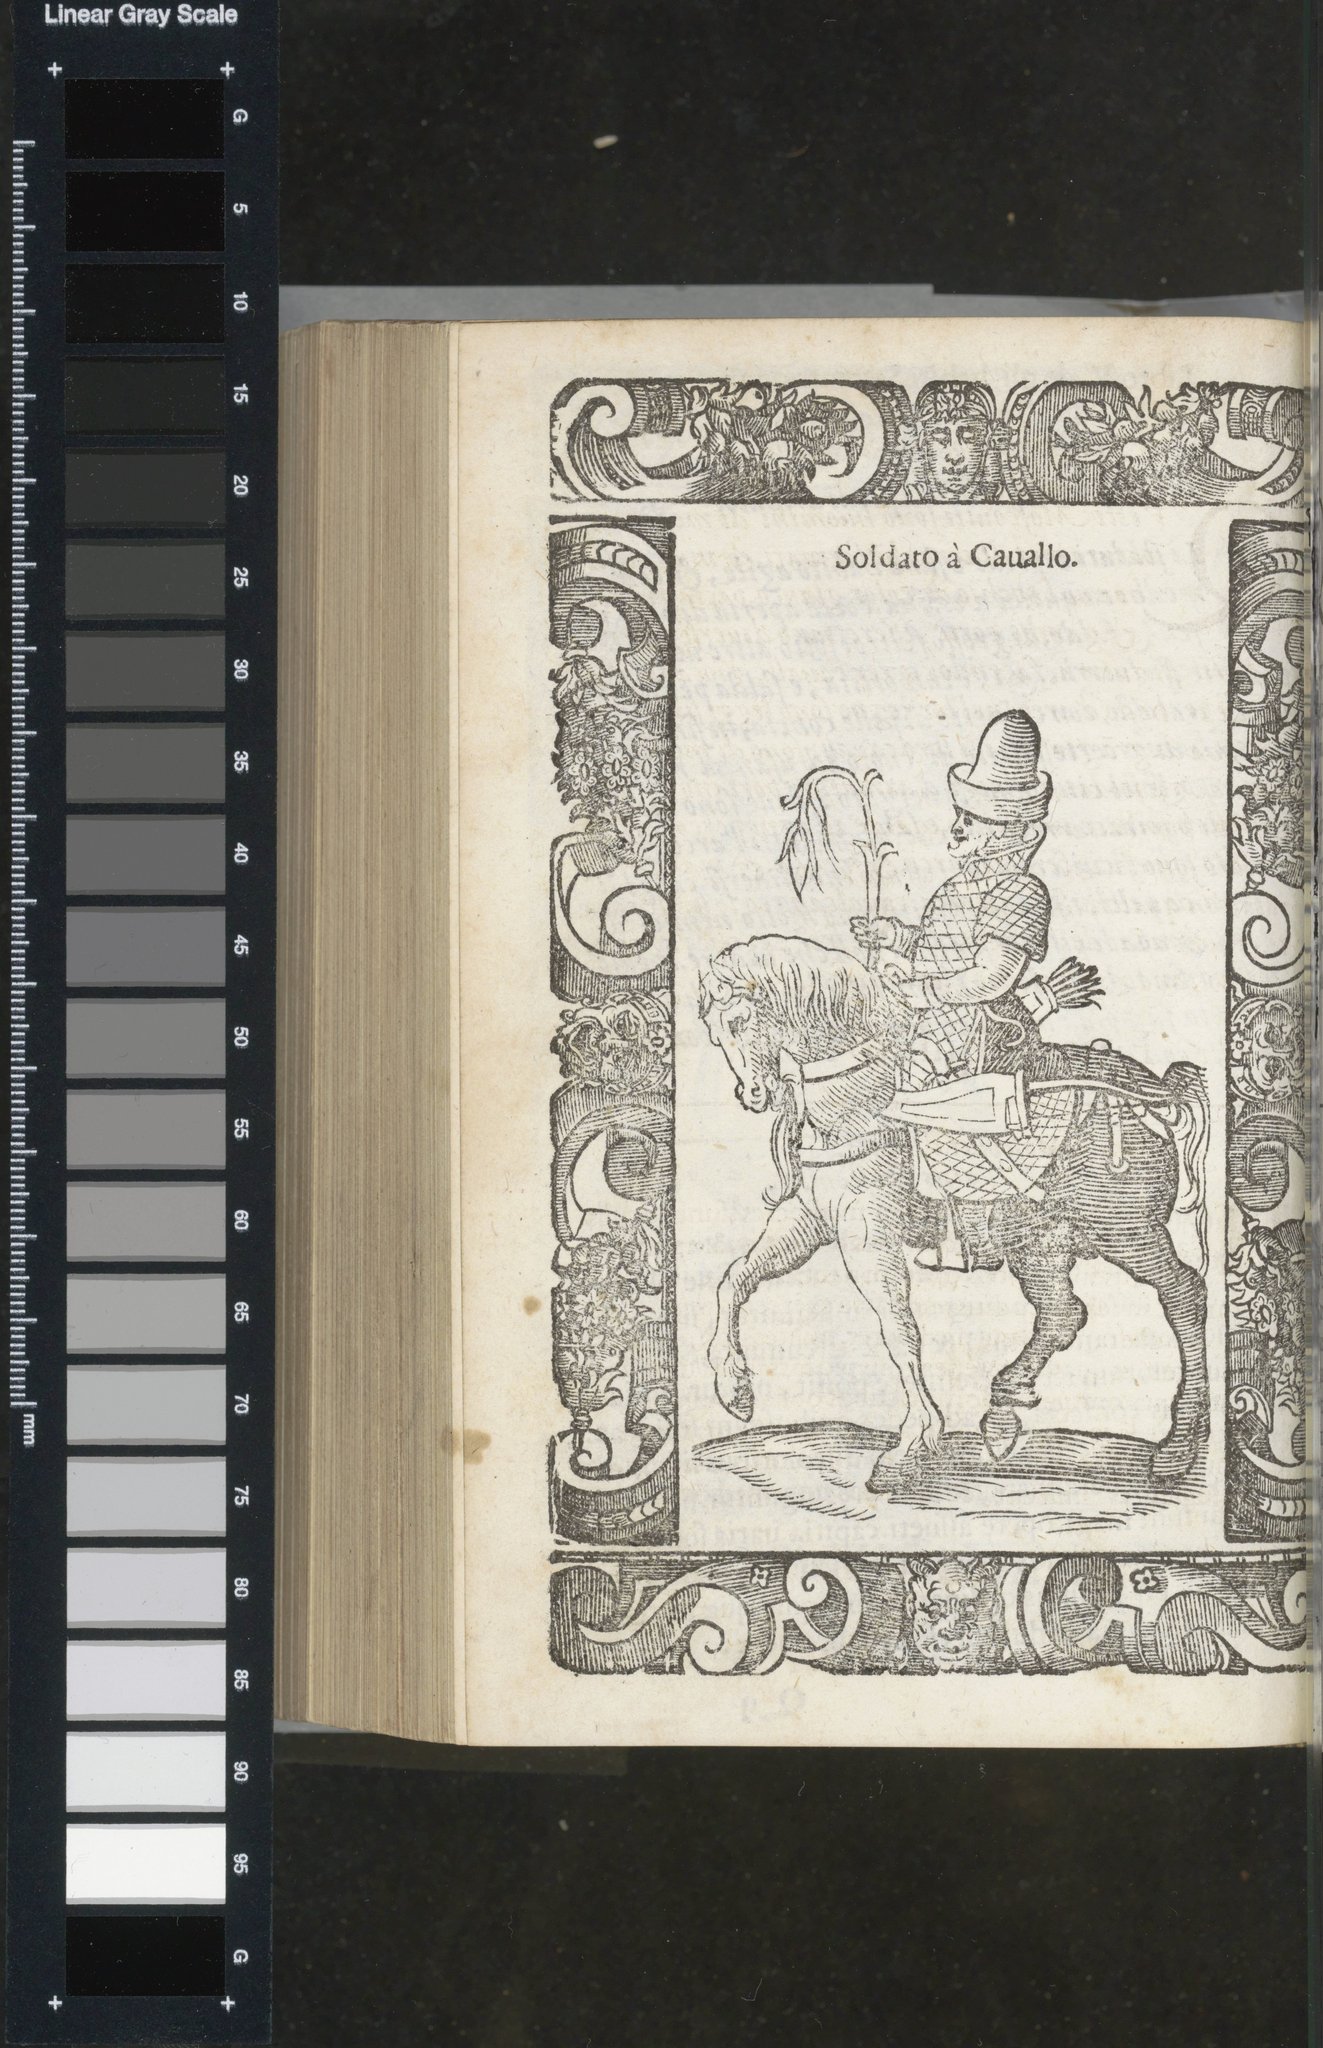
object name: costume print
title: Habiti antichi, et moderni di tutto il mondo...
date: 1598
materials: paper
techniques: woodcut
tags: fashion plates